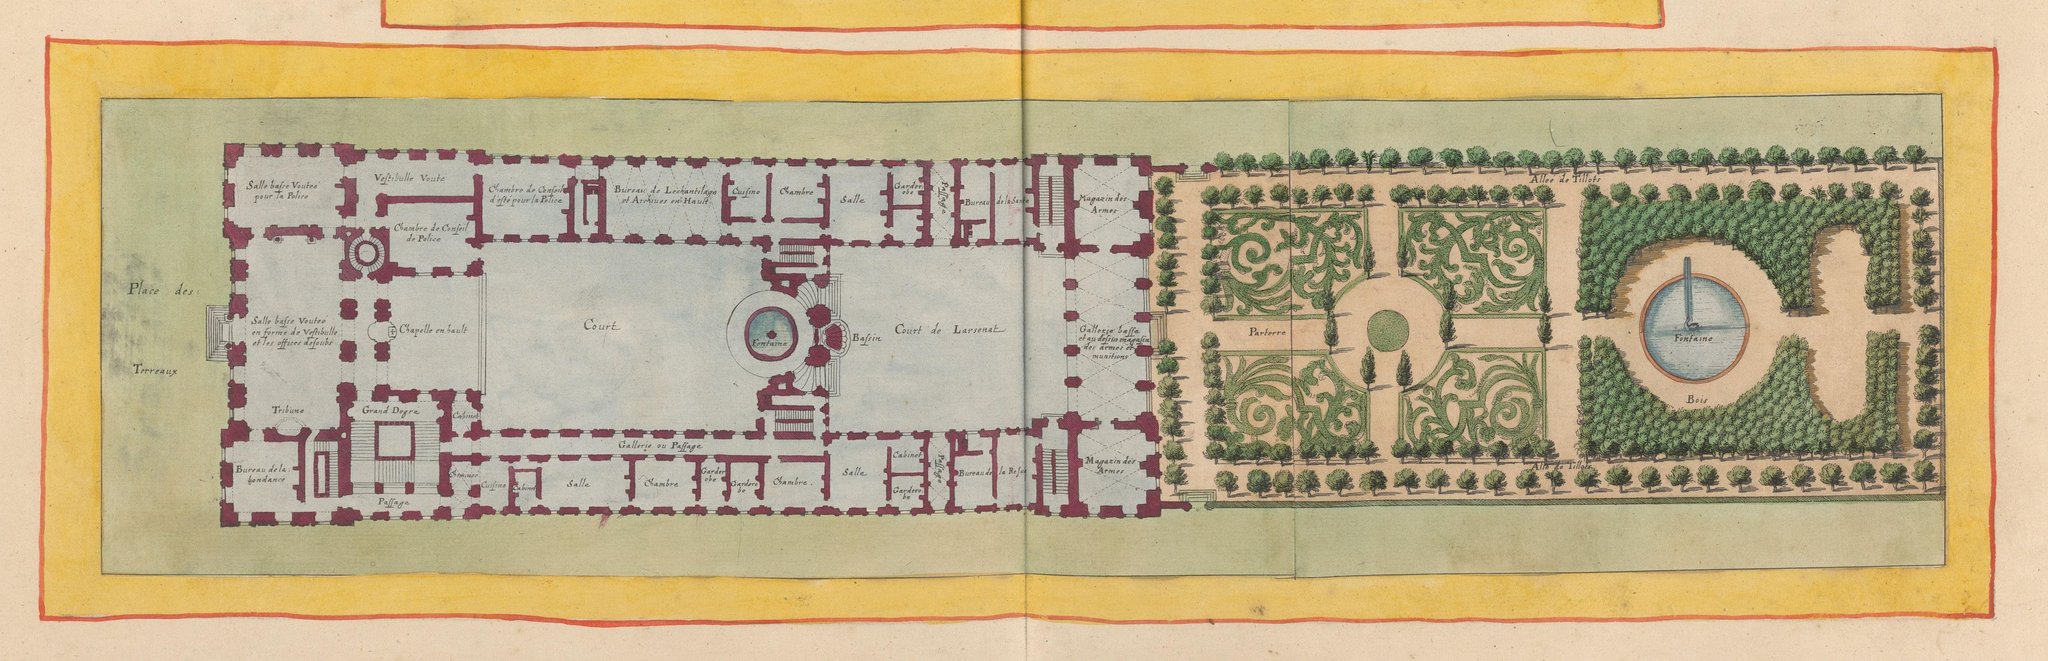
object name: print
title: Plattegrond van het stadhuis van Lyon en de tuinen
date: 1657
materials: paper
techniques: engraving, etching, hand coloring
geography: frankfurt am main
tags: plan, map of garden, townhall, lyon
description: Prent uit: Zeiller, Martin. Topographia Galliae. 13 dln. Frankfurt: Caspar Merian, 1657, dl. 5, na p. 12. Origineel op twee bladen gedrukt; de rechterhelft van deze plattegrond met het gezicht op de entree van het stadhuis (RP-P-1957-607-39-1), de linkerhelft met een gezicht op het hele stadhuis (RP-P-1957-607-2).